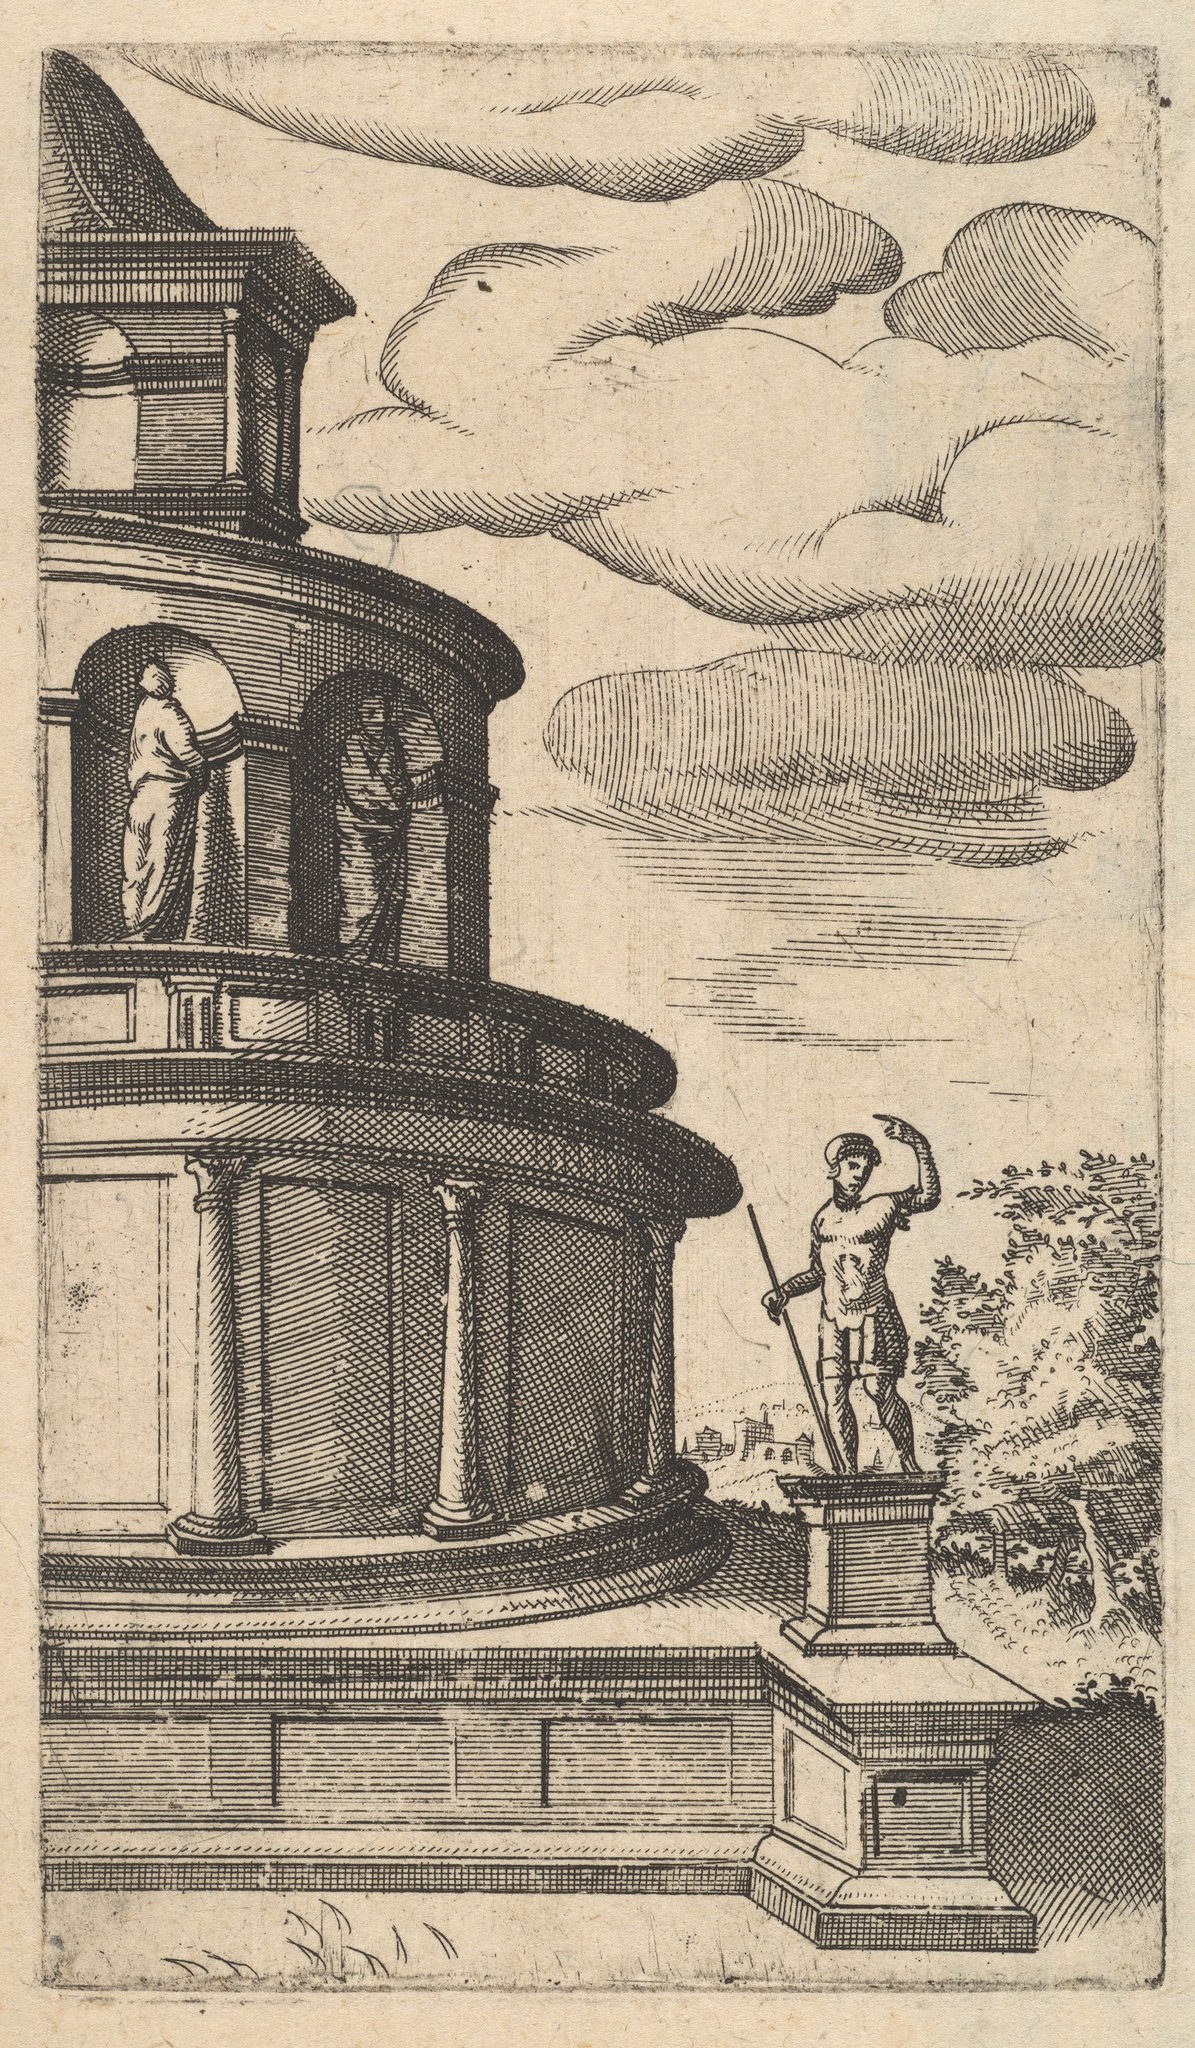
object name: book print ornament architecture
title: Partial view of a Building [Sepulchrum Adriani] from the series 'Ruinarum variarum fabricarum delineationes pictoribus caeterisque id genus artificibus multum utiles'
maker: lambert suavius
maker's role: artist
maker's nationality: netherlandish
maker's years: 1510-1576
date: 1554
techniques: etching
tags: sculpture,buildings,men